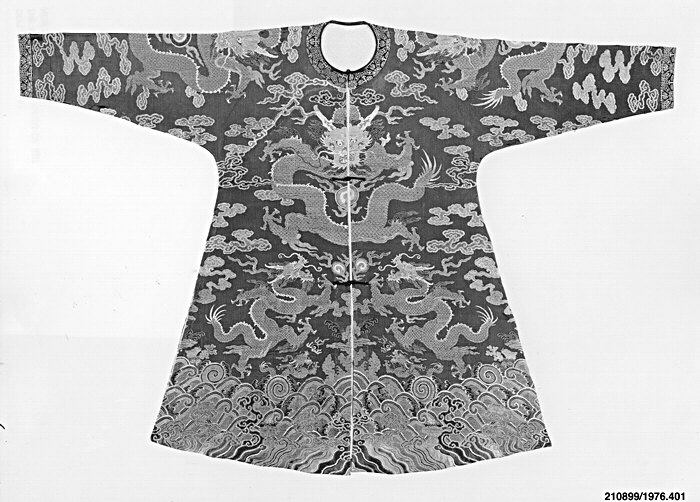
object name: short four clawed dragon robe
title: Short Four-Clawed Dragon Robe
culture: chinese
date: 1723-1735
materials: silk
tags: dragons